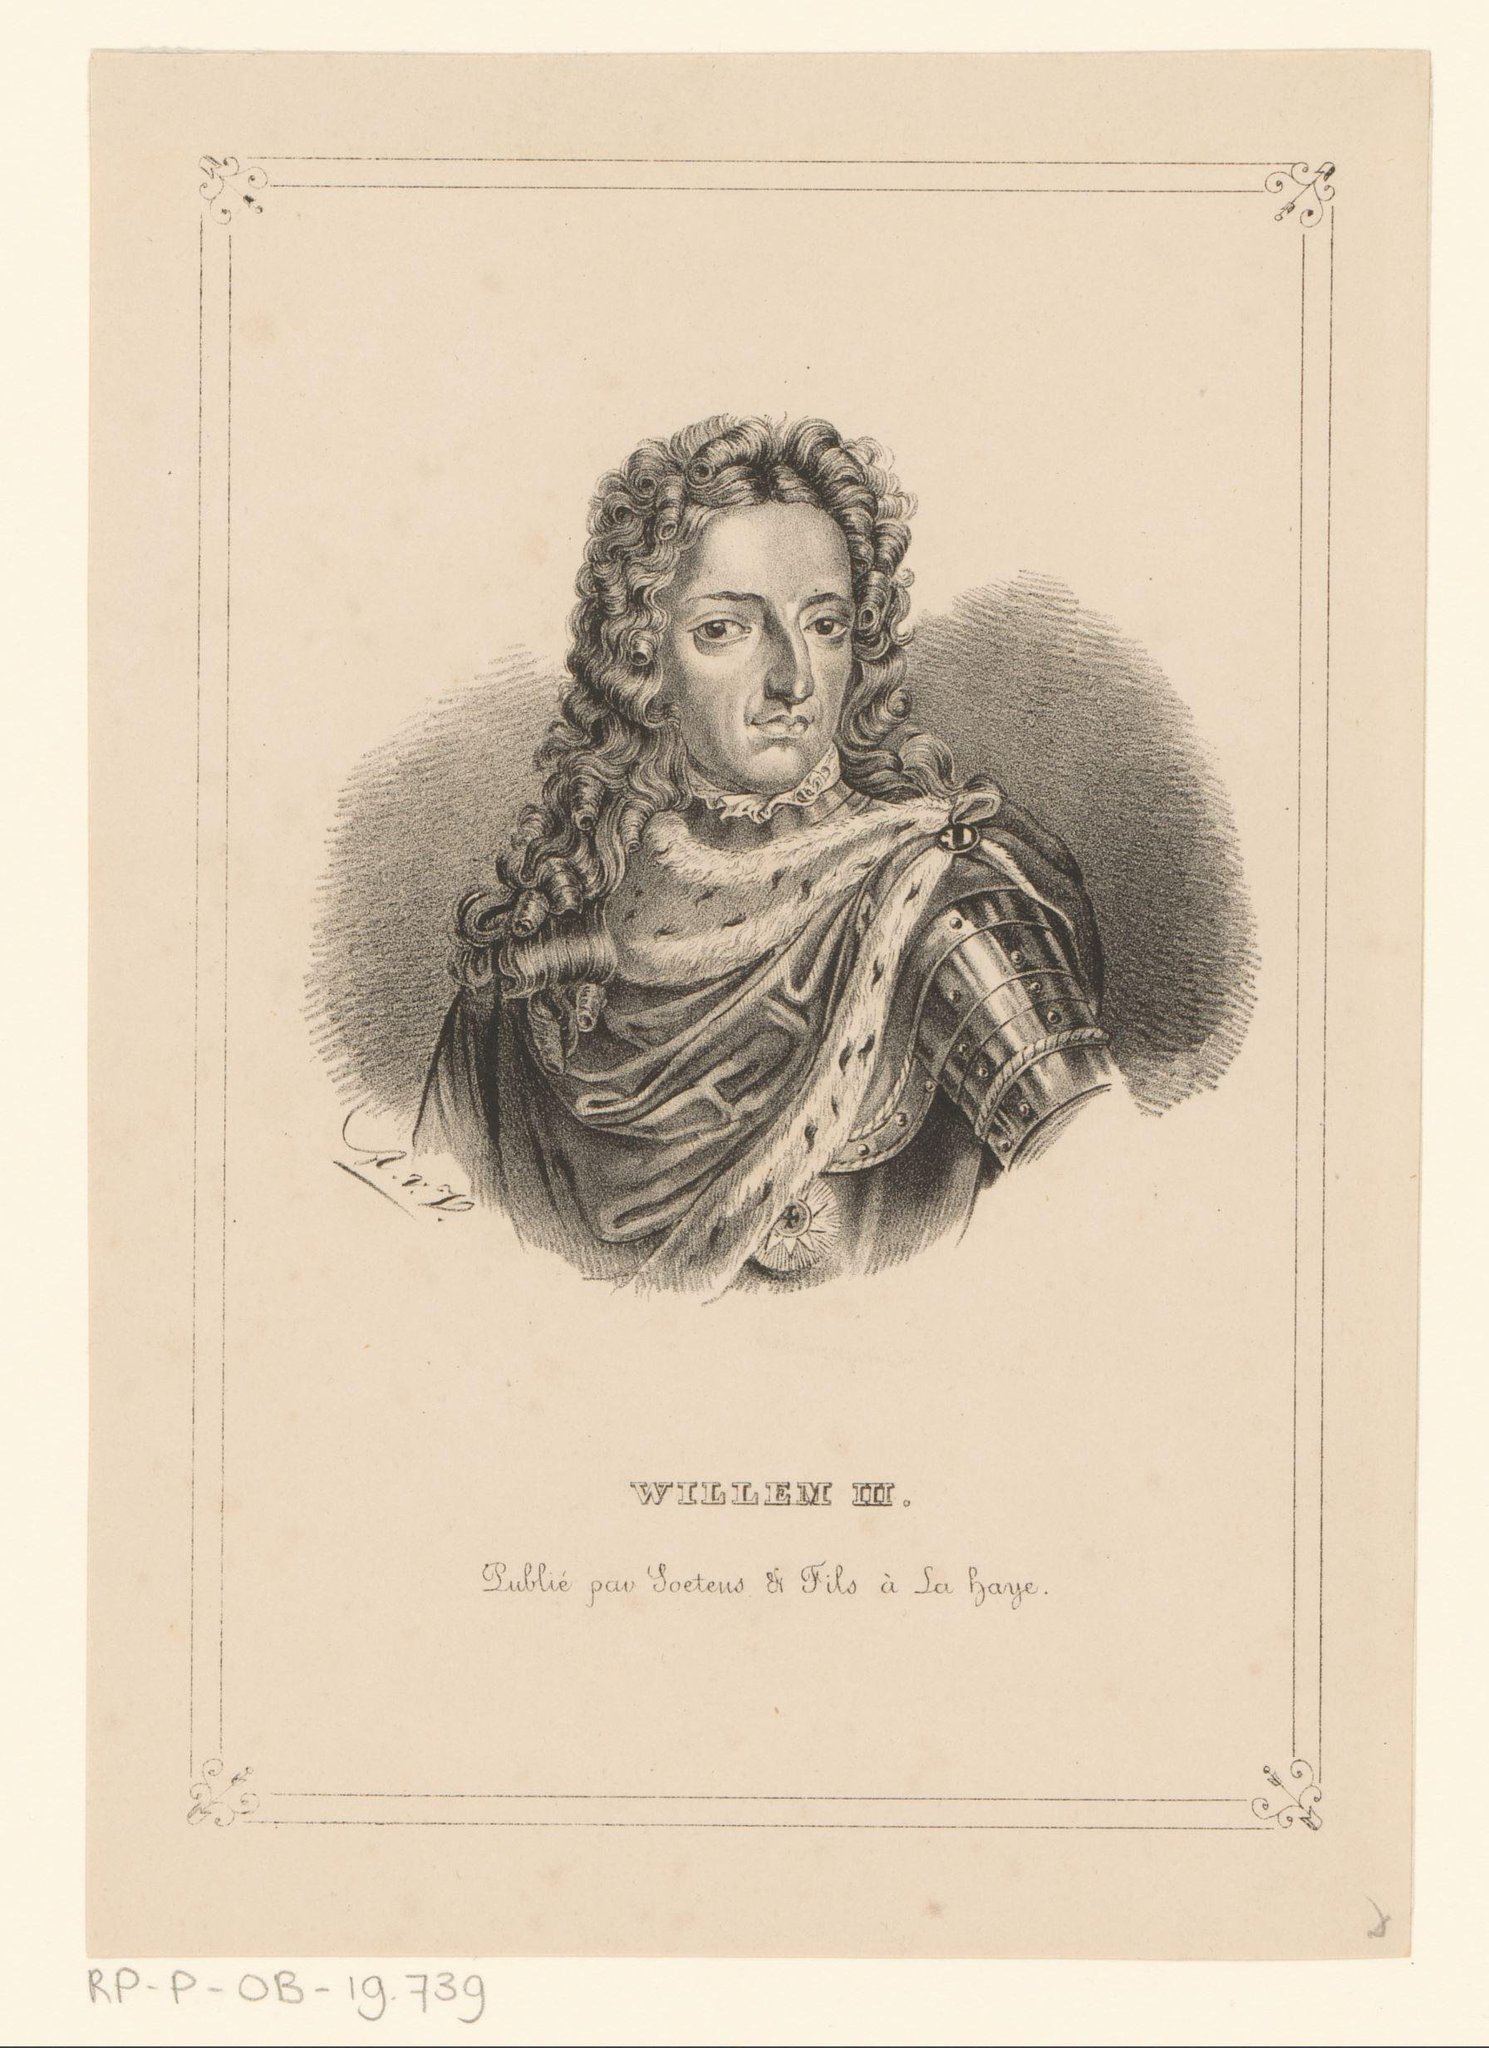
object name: print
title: Willem III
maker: anthonie van volkom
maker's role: print maker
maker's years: 1821-1860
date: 1837-1840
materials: paper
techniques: lithograph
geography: the hague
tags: the hague, william iii (prince of orange and king of england, scotland, and ireland), historical persons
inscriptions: collector's mark: Lugt 2228